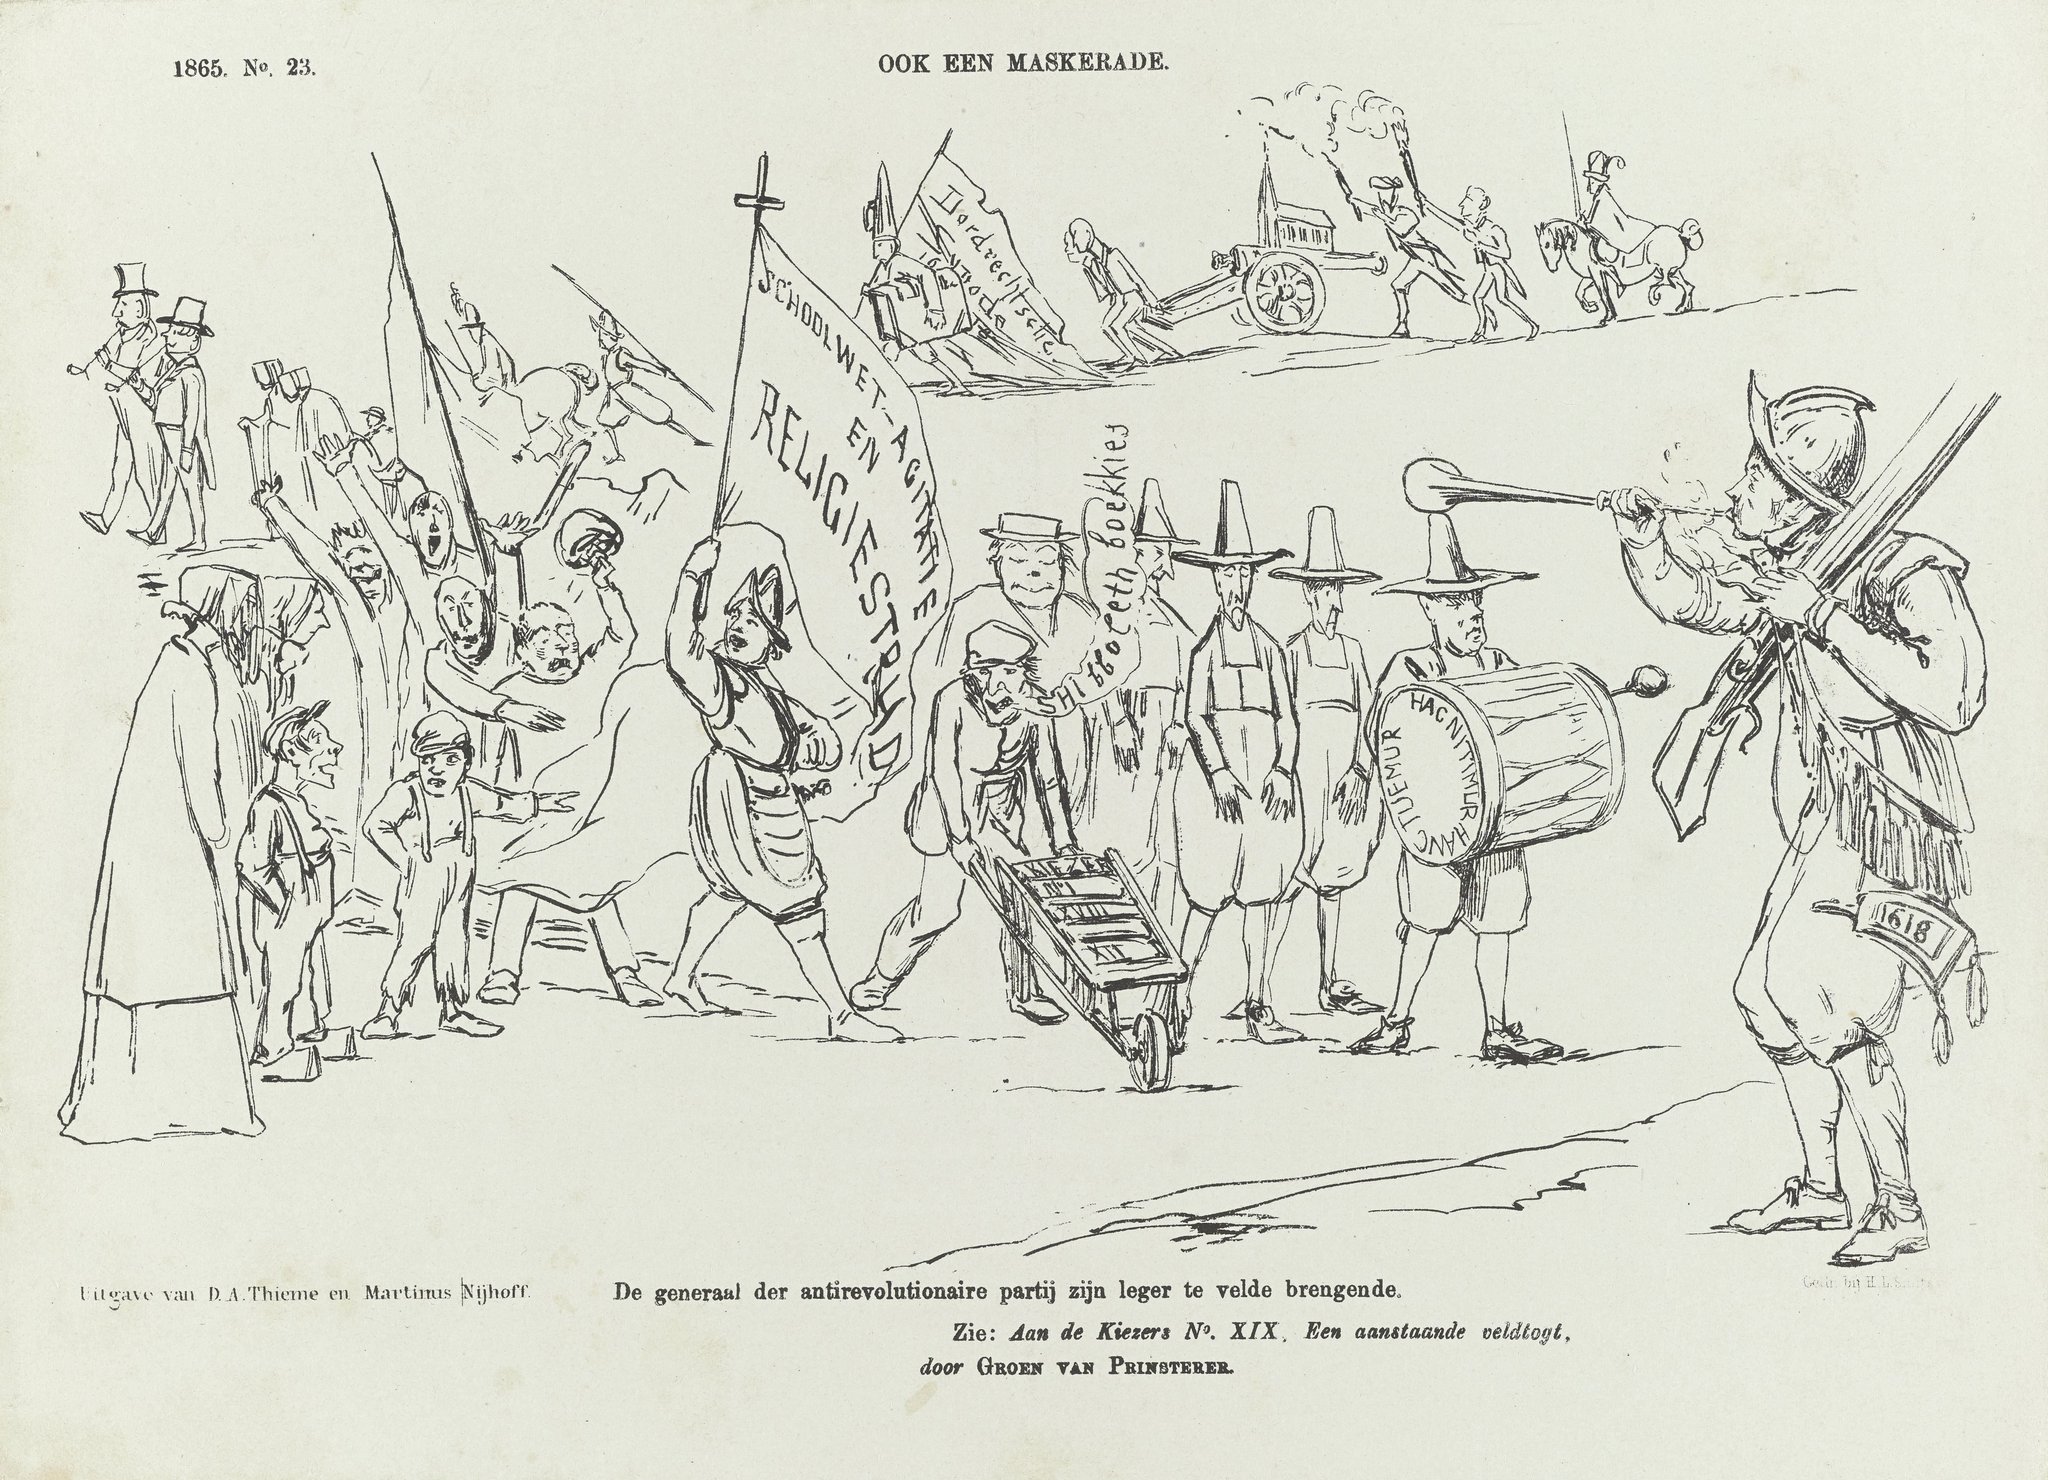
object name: print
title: Spotprent op het programma van de antirevolutionairen tegen de schoolwet, 1865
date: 1865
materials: paper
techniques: lithograph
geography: netherlands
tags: guillaume groen van prinsterer, assembling of military forces; mobilization, troop concentration, etc.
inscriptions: collector's mark: Lugt 2228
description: Spotprent op het programma van de antirevolutionairen tegen de schoolwet. Groen van Prinsterer als trompetter die zijn troepen verzamelt. Plaat verschenen bij het weekblad De Nederlandsche Spectator, nr. 23, 10 juni 1865.